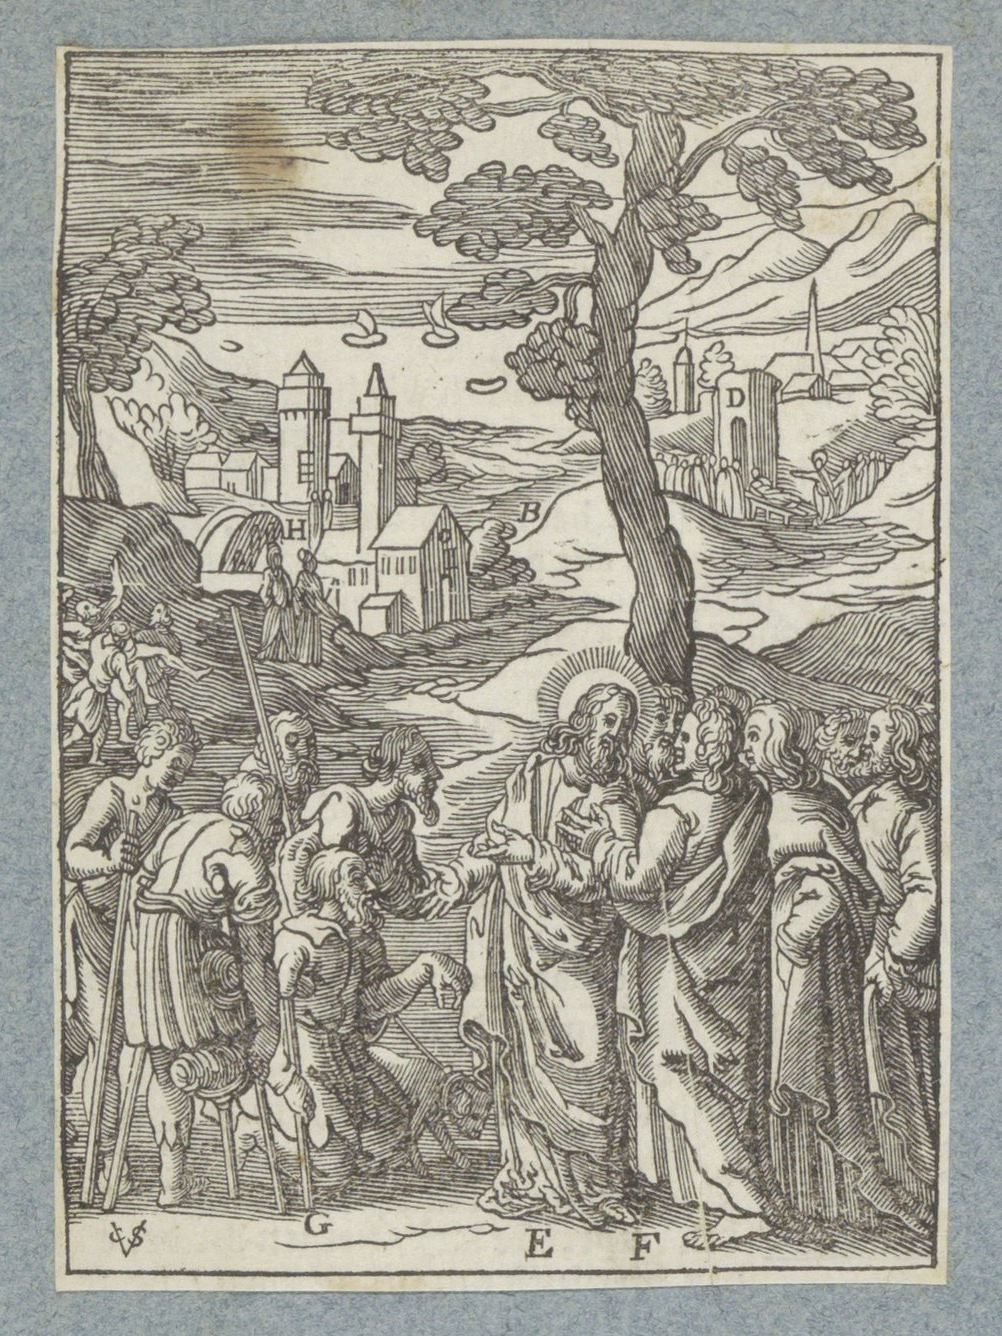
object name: album leaf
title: Christus antwoordt de boodschappers van Johannes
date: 1629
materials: paper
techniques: letterpress printing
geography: amsterdam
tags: christ explaining his doctrine to the apostles and disciples, disabilities, deformations, two disciples of john the baptist are sent to christ (matthew 11:2-6; luke 7:18-23)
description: Johannes hoort in de gevangenis over het optreden van Christus. Hij stuurt enkele van zijn leerlingen naar hem toe om hem vragen te stellen. In hun aanwezigheid geneest Christus mensen met beperkingen zoals blindheid, doofheid en verlamming. Bij verschillende elementen uit de voorstelling staan letters. De prent maakt deel uit van een album. Matt: 15:30.